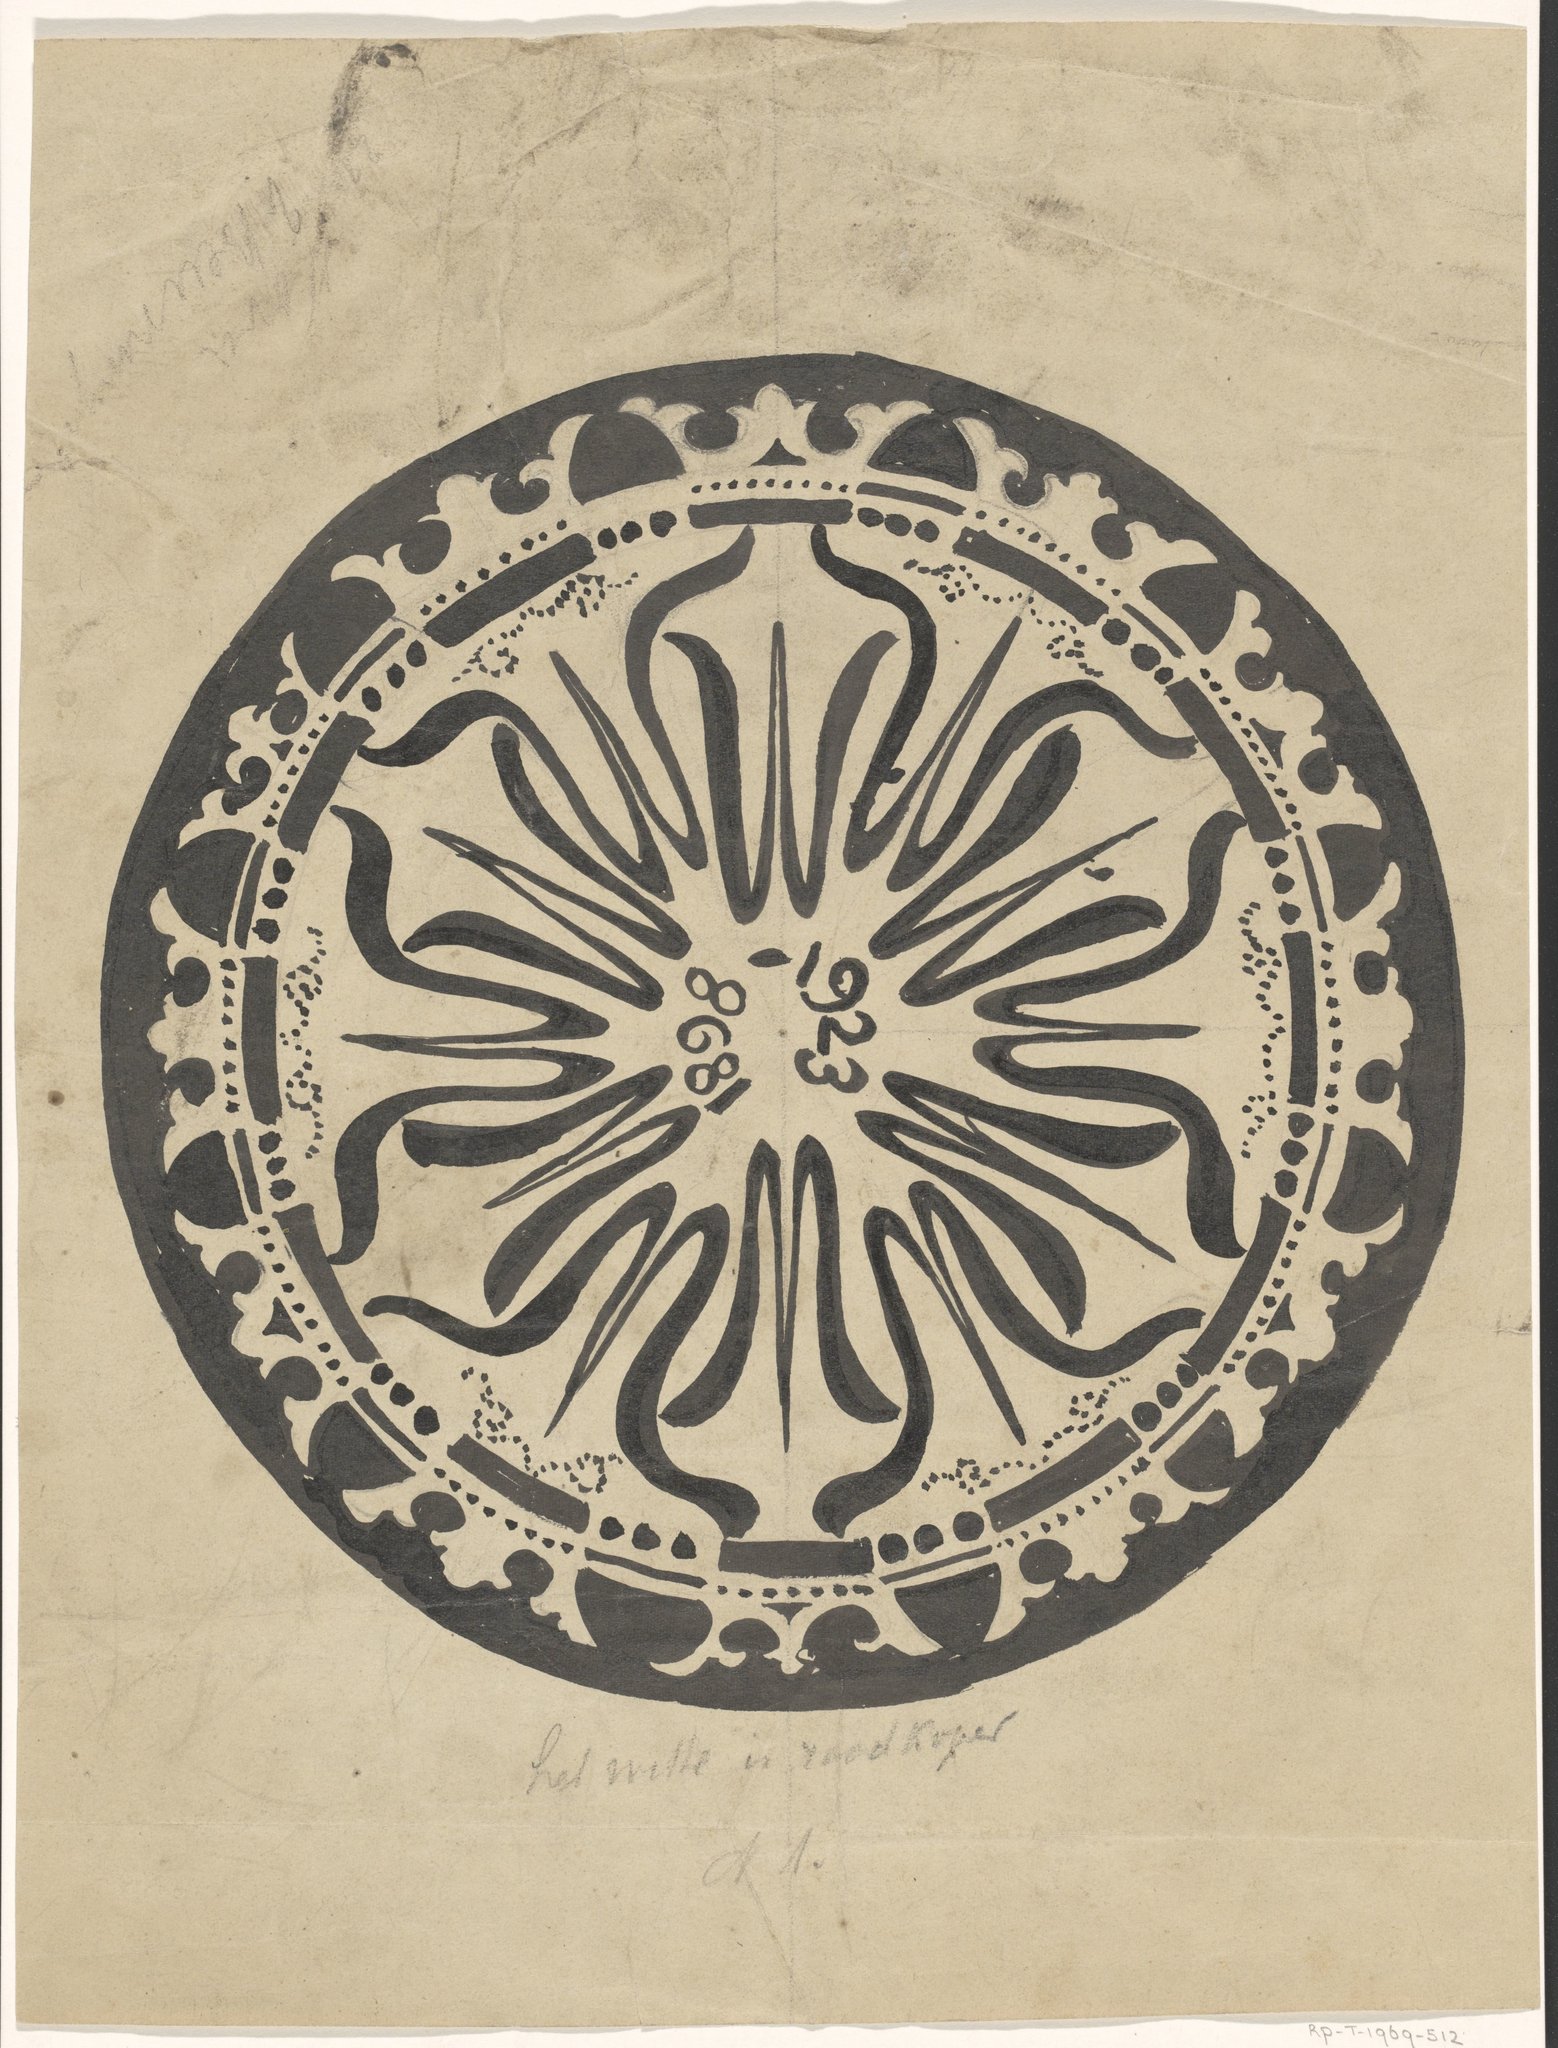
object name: design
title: Ontwerp voor een bord ter gelegenheid van het zilveren jubileum van koningin Wilhelmina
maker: carel adolph lion cachet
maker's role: draughtsman, print maker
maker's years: 1864-1945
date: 1874-1945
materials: paper, pencil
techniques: brush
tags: the hague, wilhelmina of the netherlands, work of applied art (+ ceramics ~ arts), ball, formal dance, historical persons, dish, plate, saucer, installation of a ruler, historical events and situations, netherlands